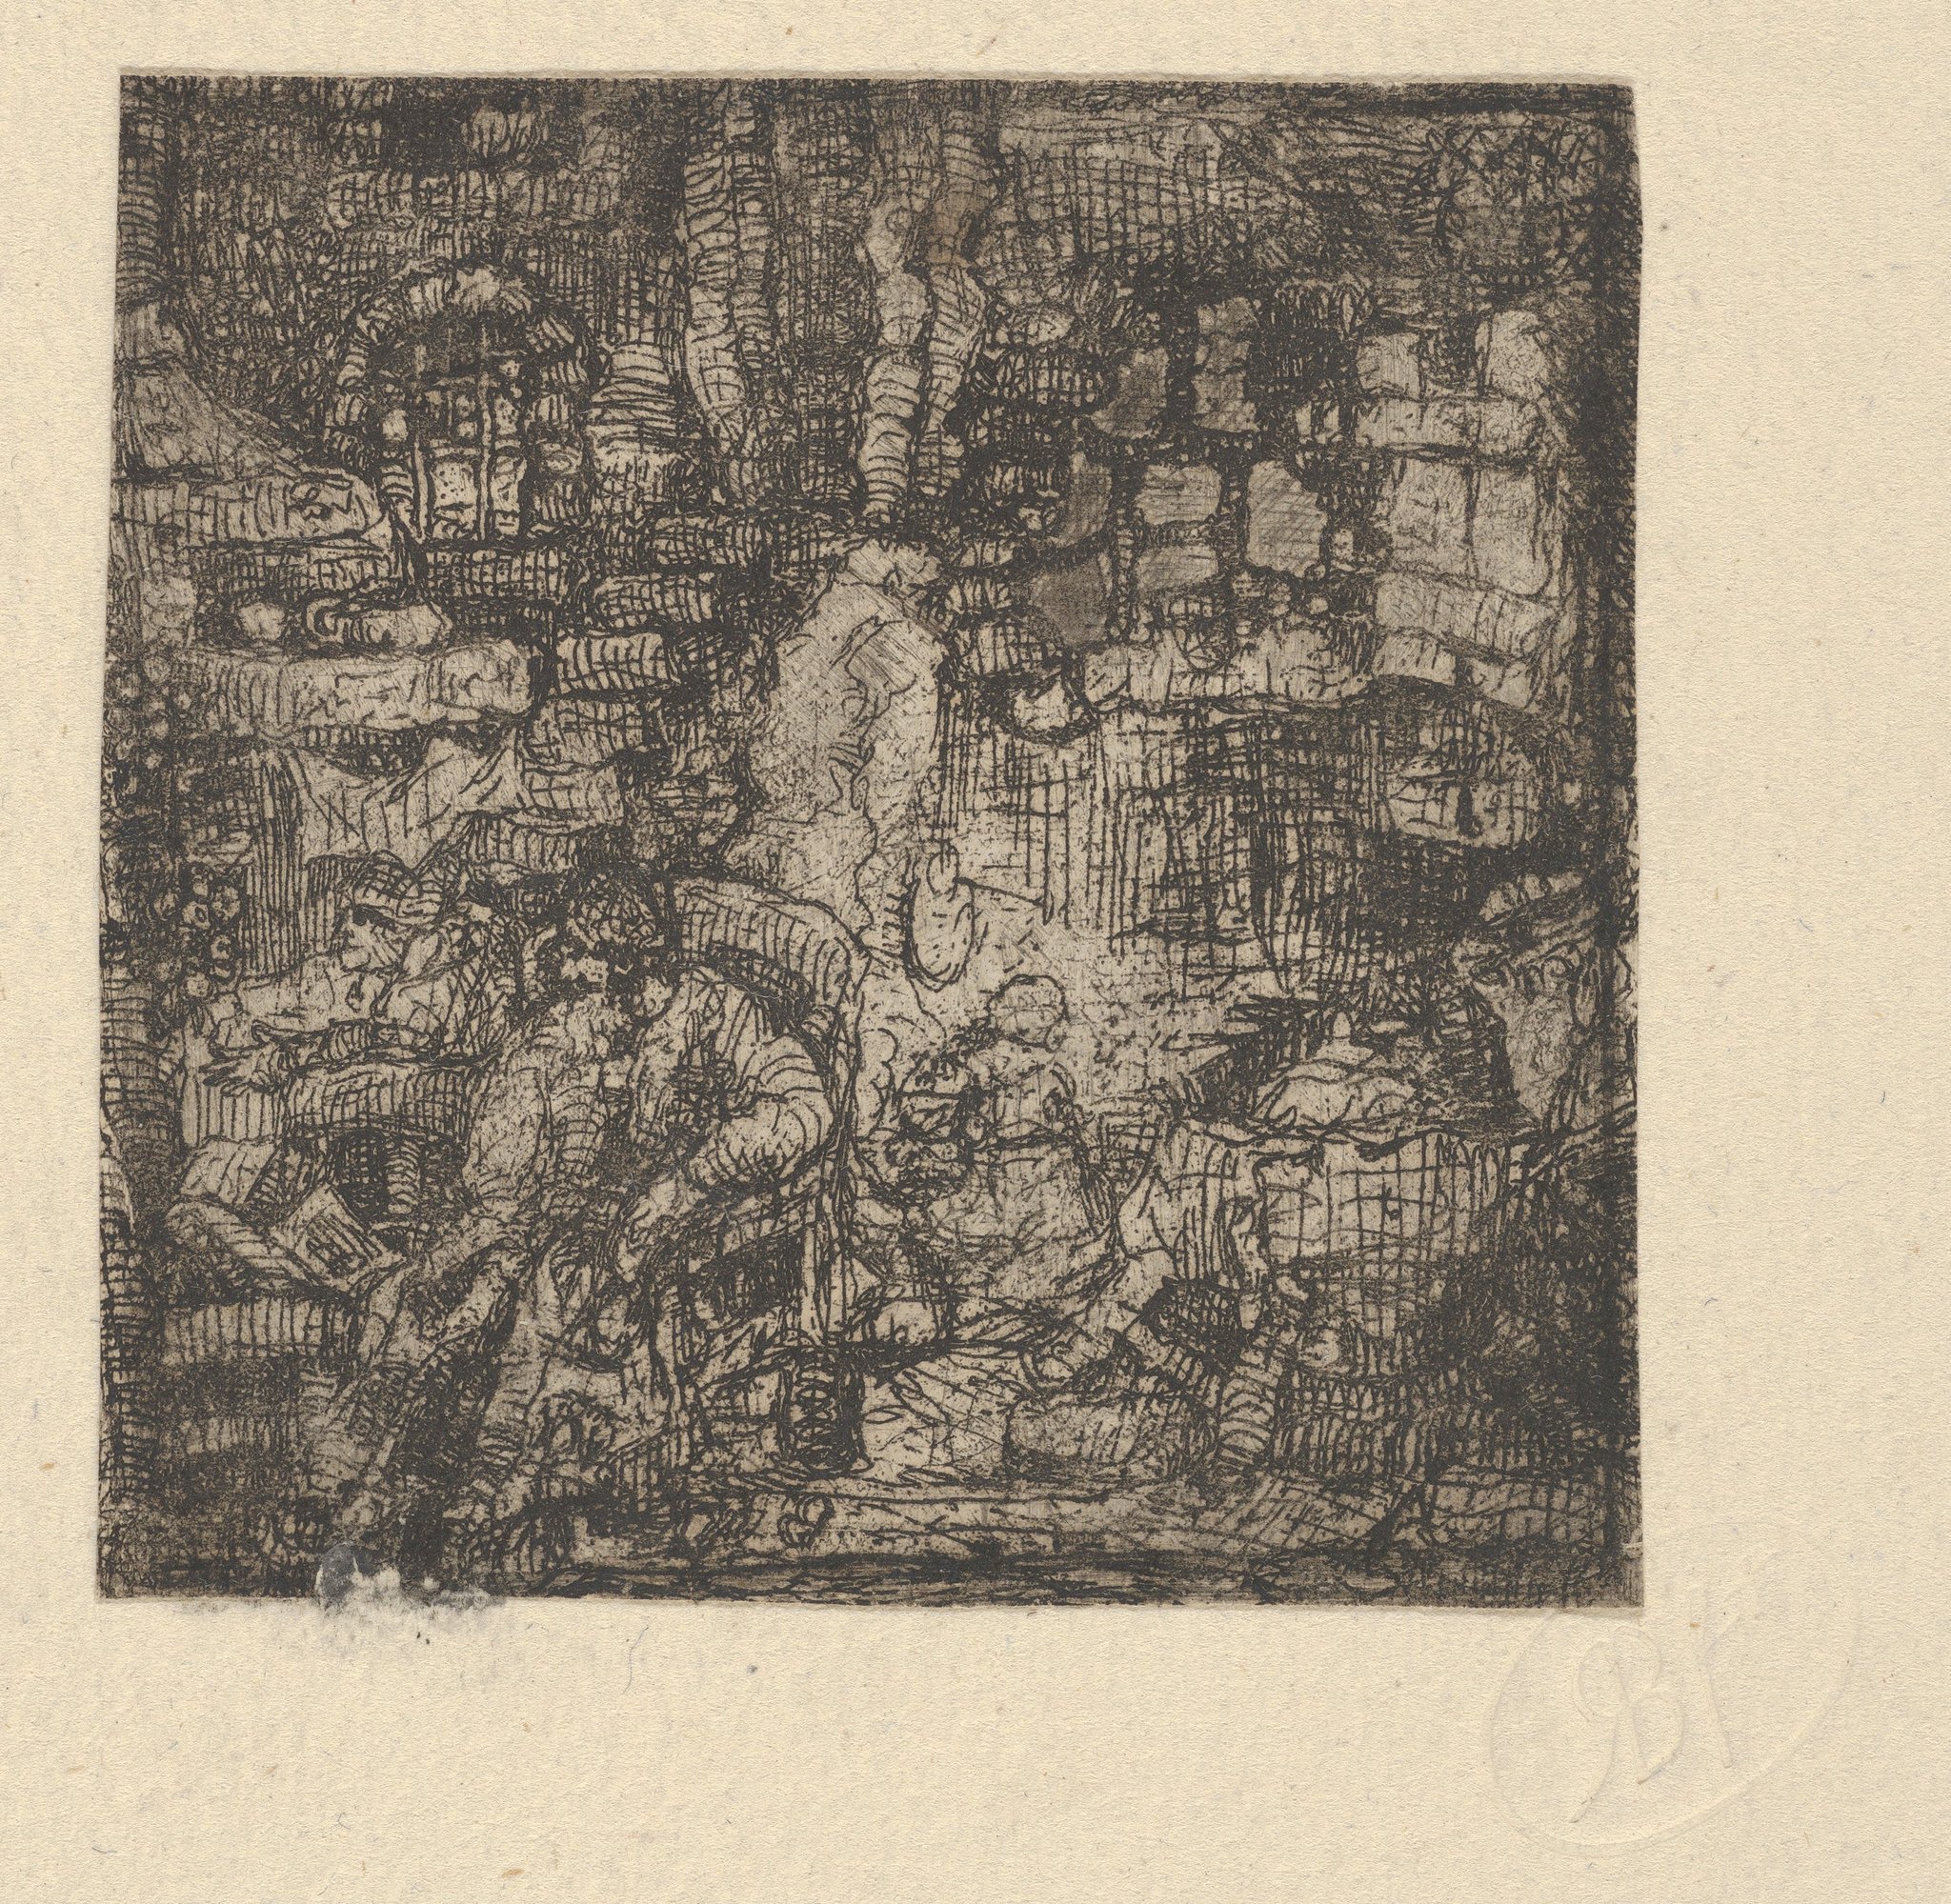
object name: print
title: Vieillard Assis Dans un Intérieur (Old Man Seated in an Interior)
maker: rodolphe bresdin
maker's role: artist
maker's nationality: french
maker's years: 1822-1885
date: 1841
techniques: etching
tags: men